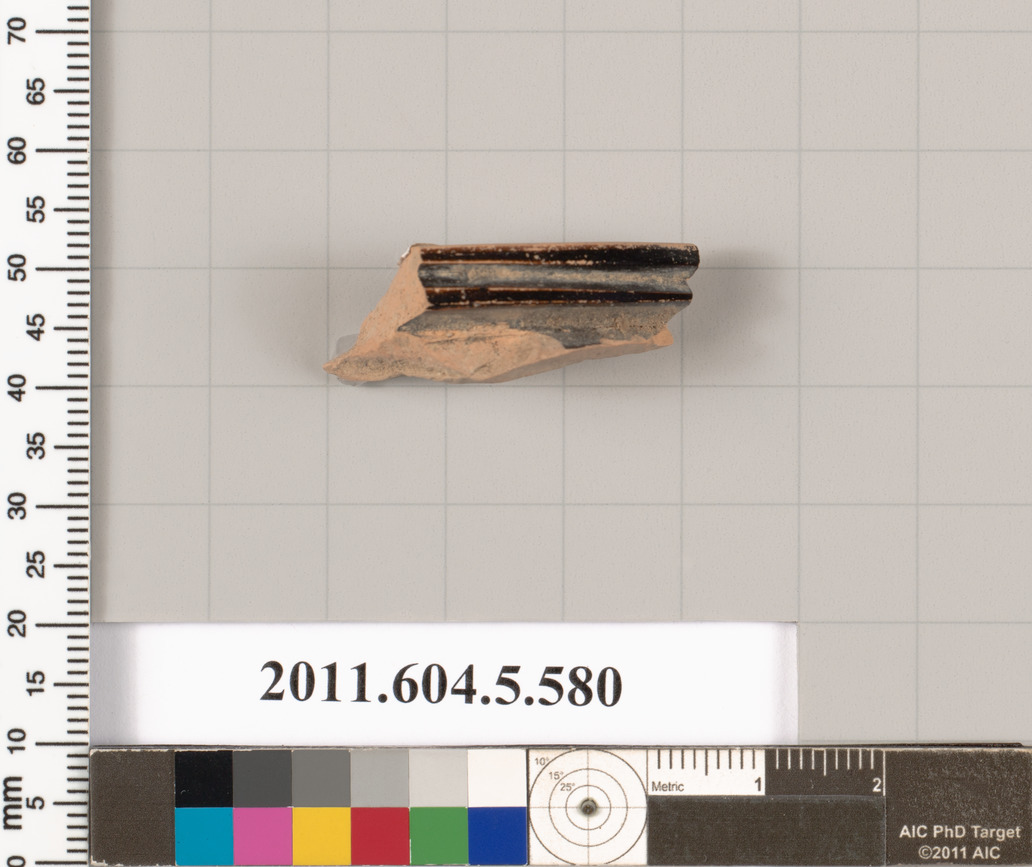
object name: stemless kylix fragment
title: Terracotta fragment of a stemless kylix (drinking cup)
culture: greek, attic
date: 600-401 BCE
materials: terracotta